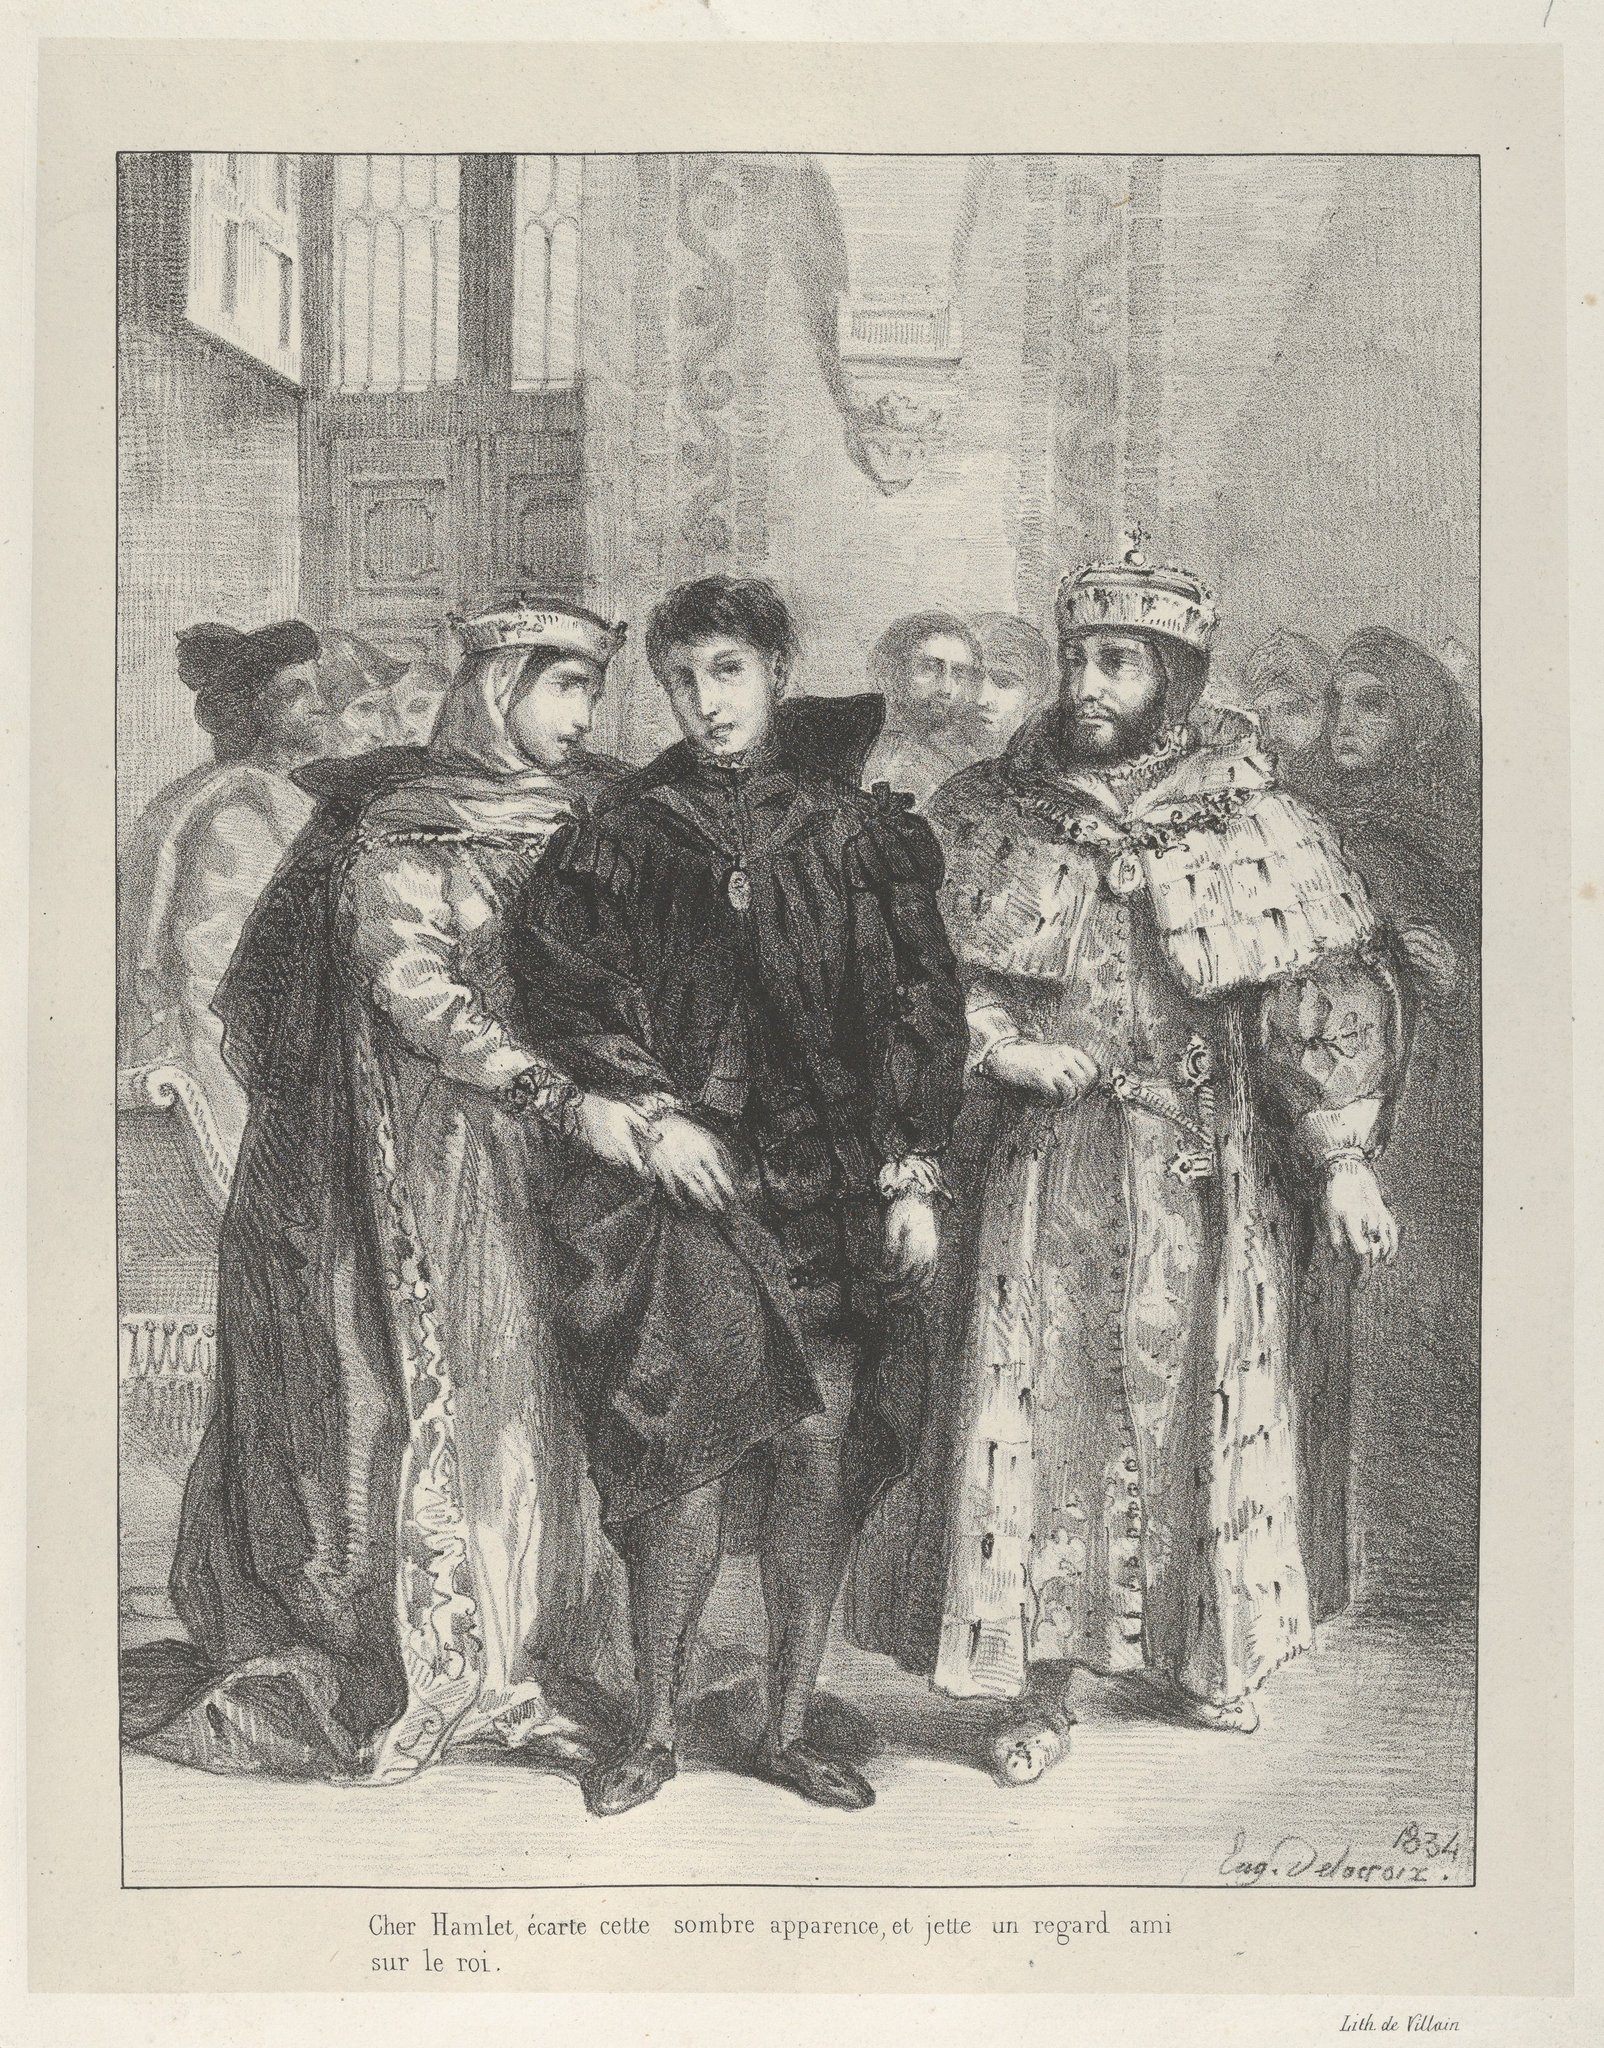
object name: print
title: The Queen Tries to Console Hamlet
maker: eugène delacroix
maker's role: artist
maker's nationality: french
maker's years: 1798-1863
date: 1834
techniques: lithograph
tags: queens,shakespeare,men,hamlet